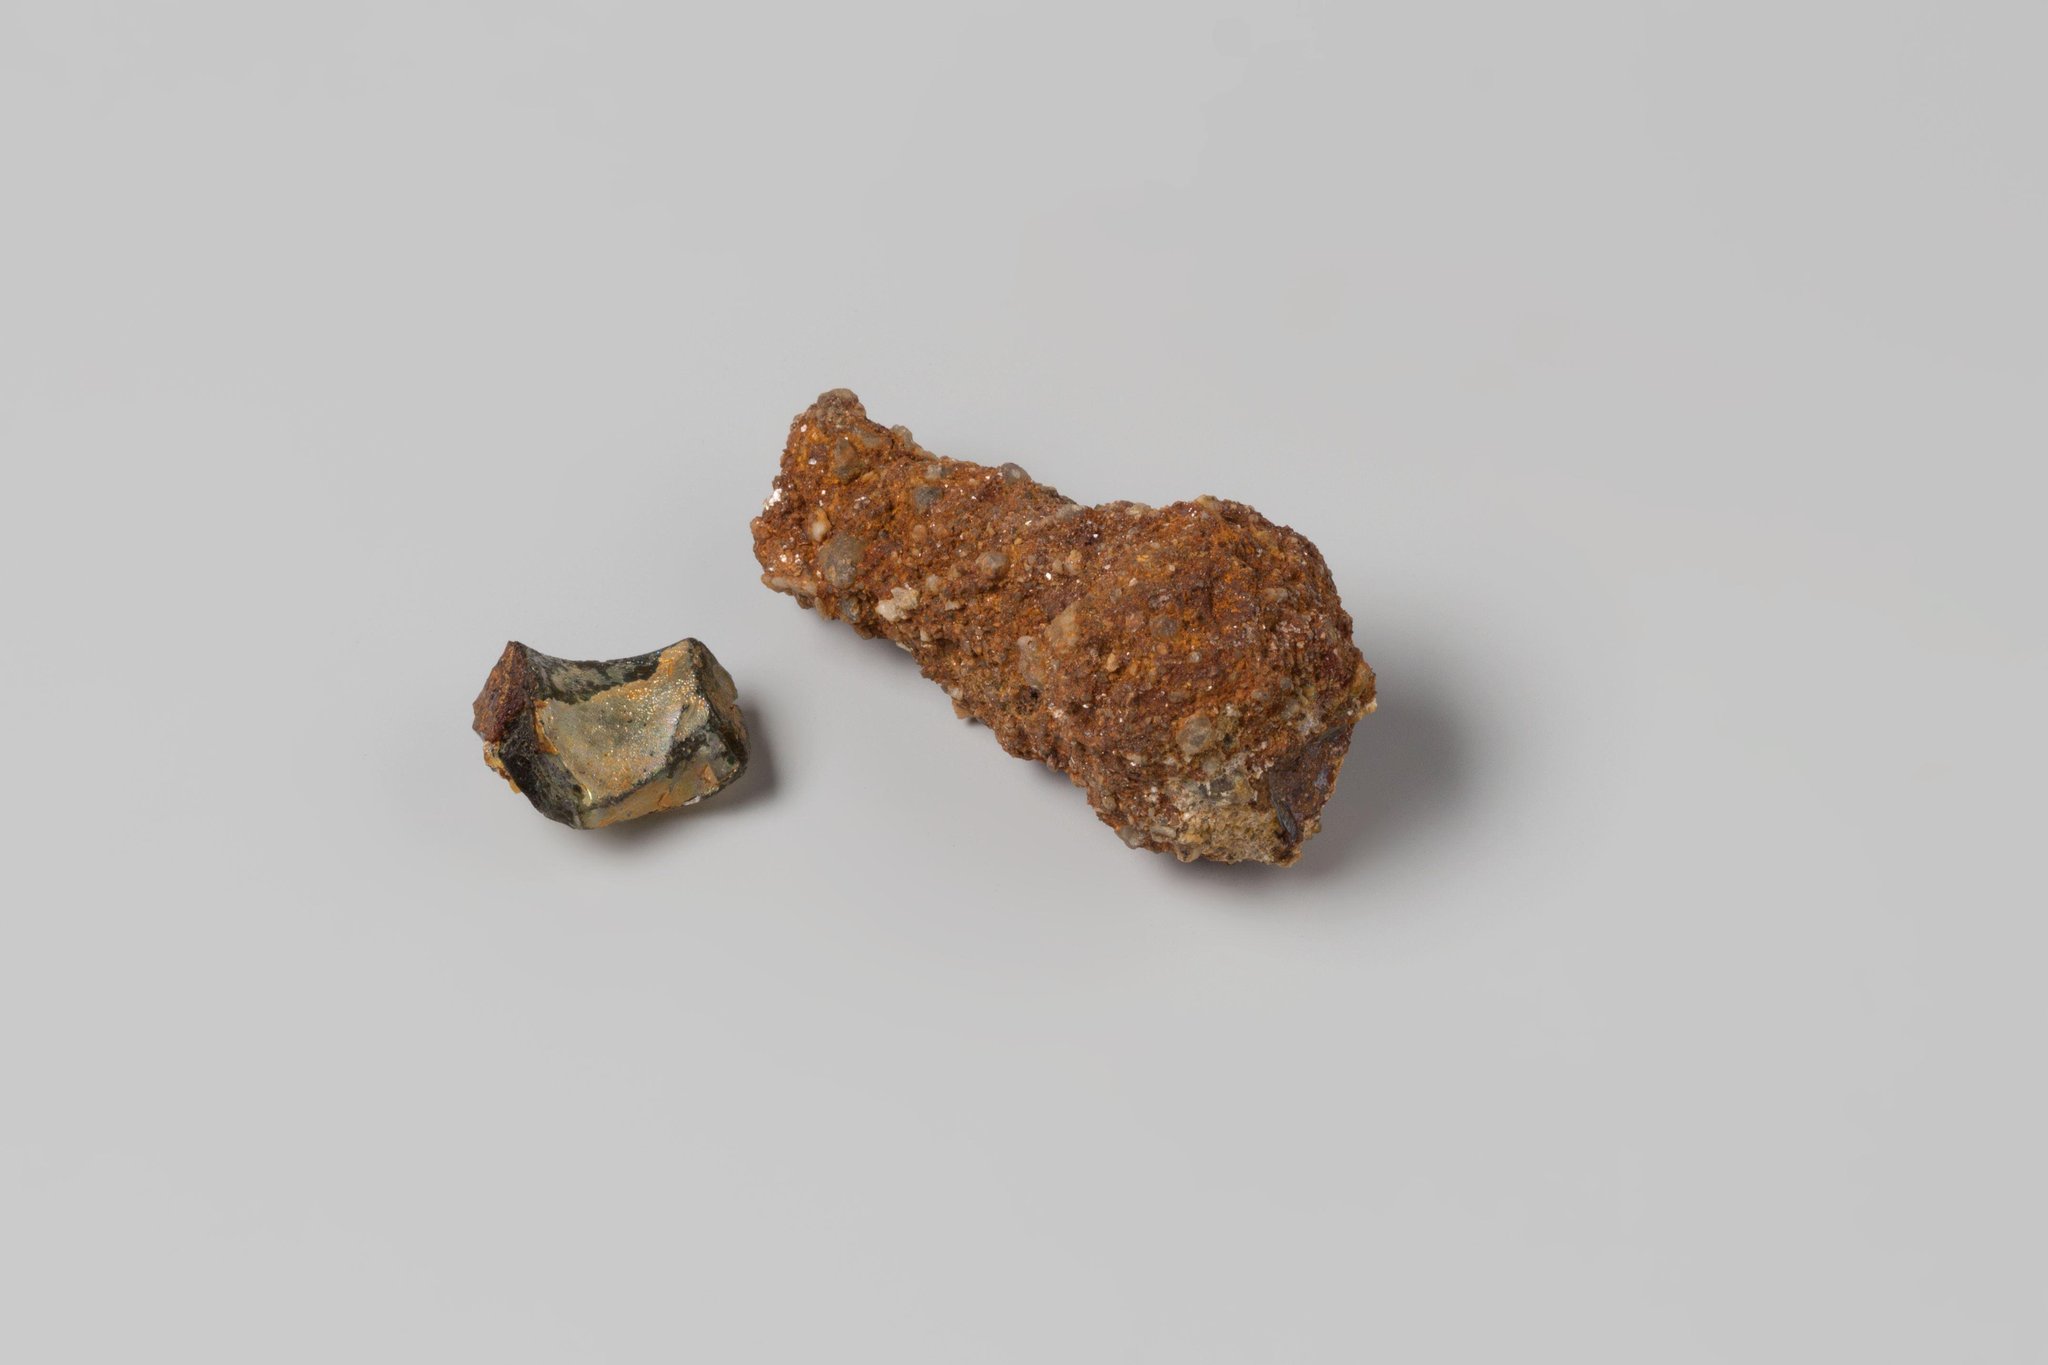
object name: concretionary stone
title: Concretie en glasscherf uit het wrak van de Oost-Indiëvaarder Hollandia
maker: Anonymous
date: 1700-1743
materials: stone, glass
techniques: green glass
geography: netherlands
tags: verenigde oostindische compagnie, hollandia (schip), annet